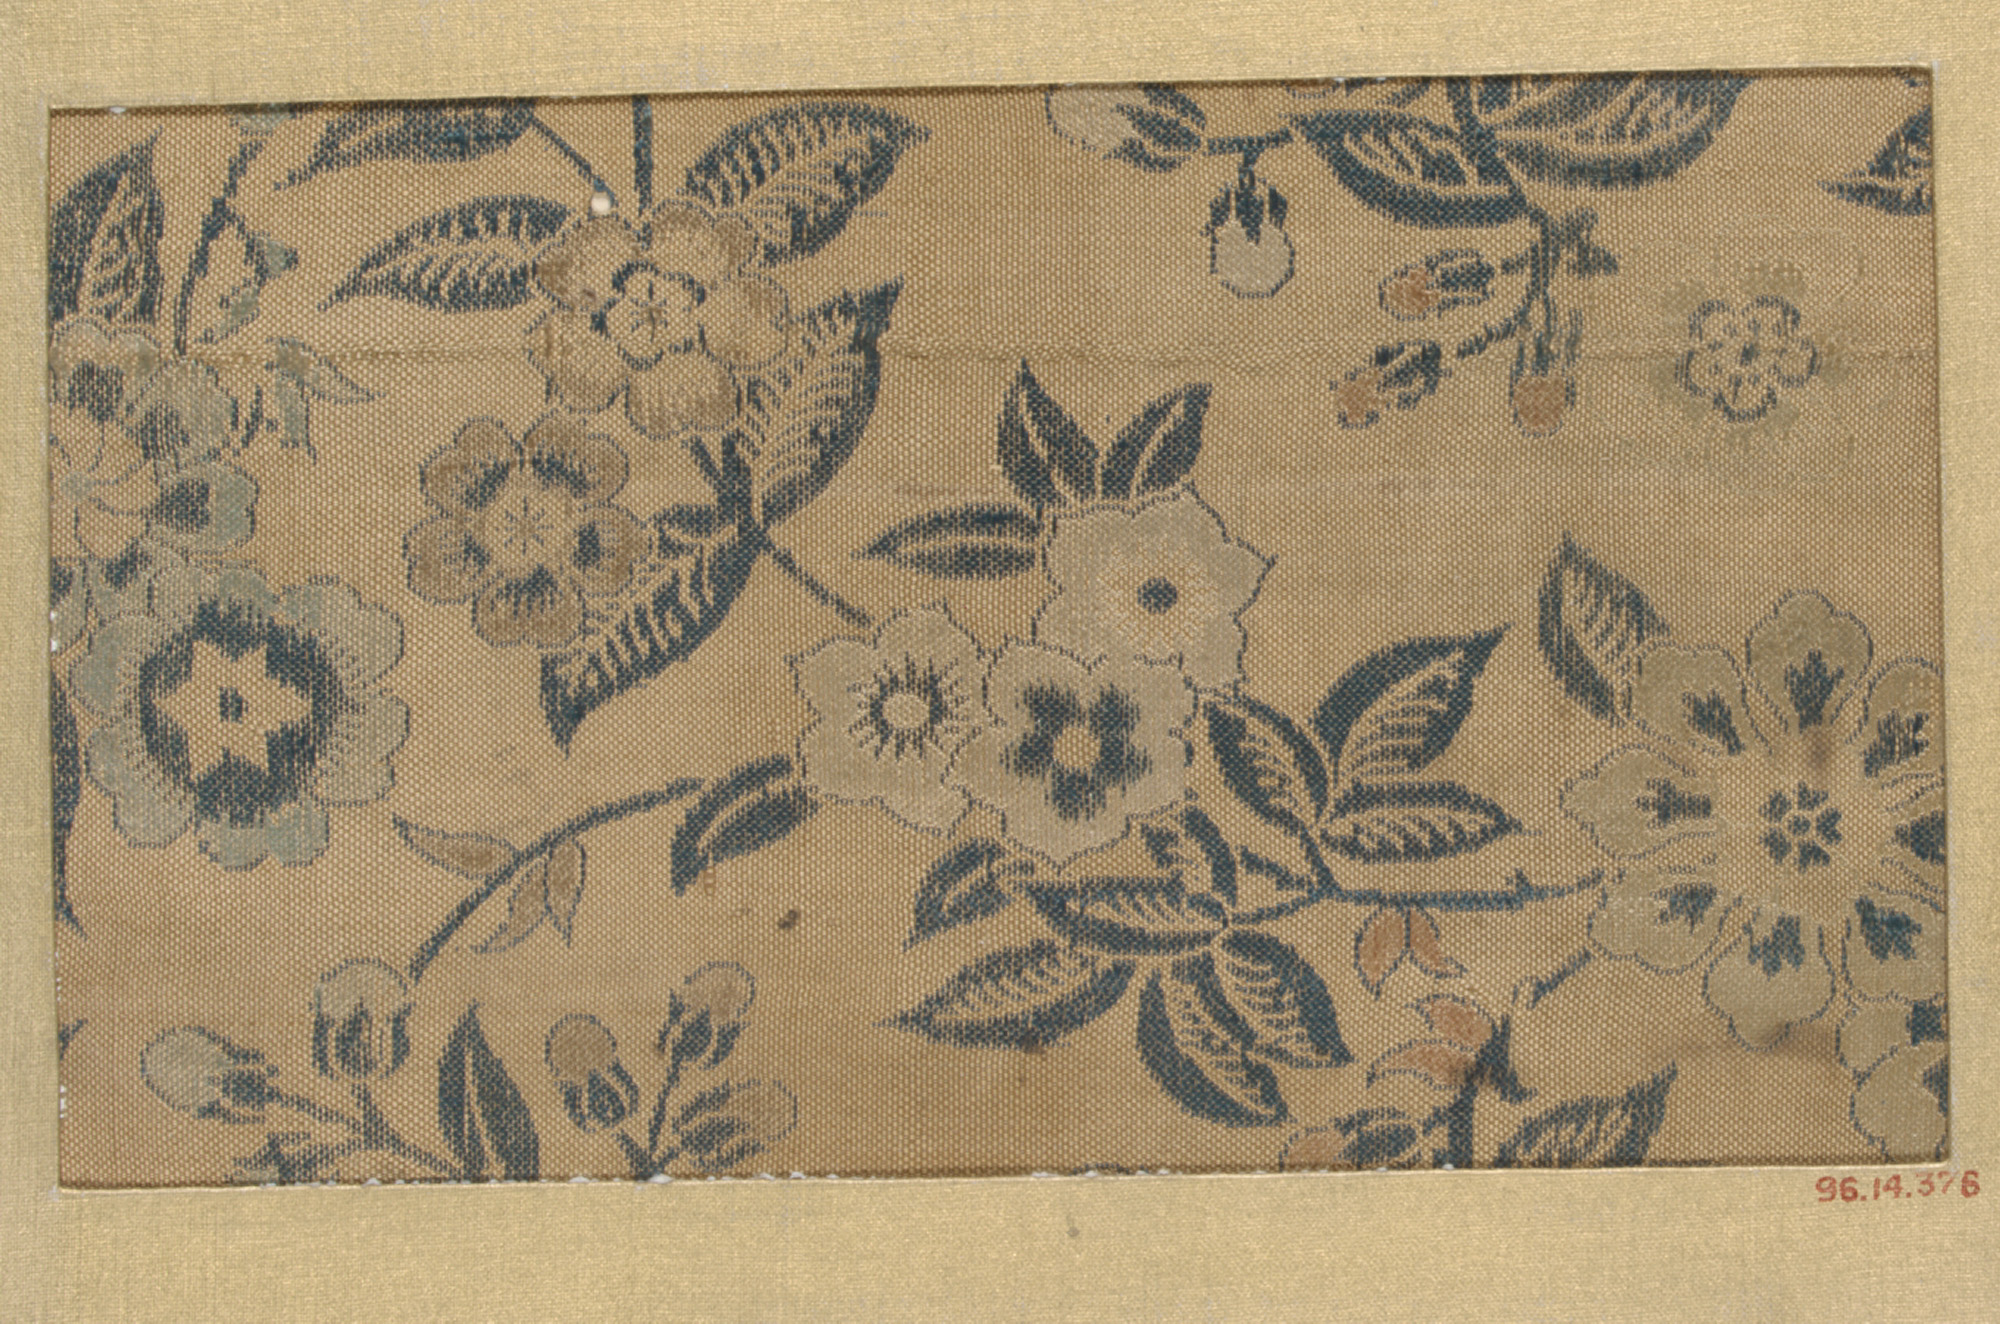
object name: piece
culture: japanese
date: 1701-1900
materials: silk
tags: leaves